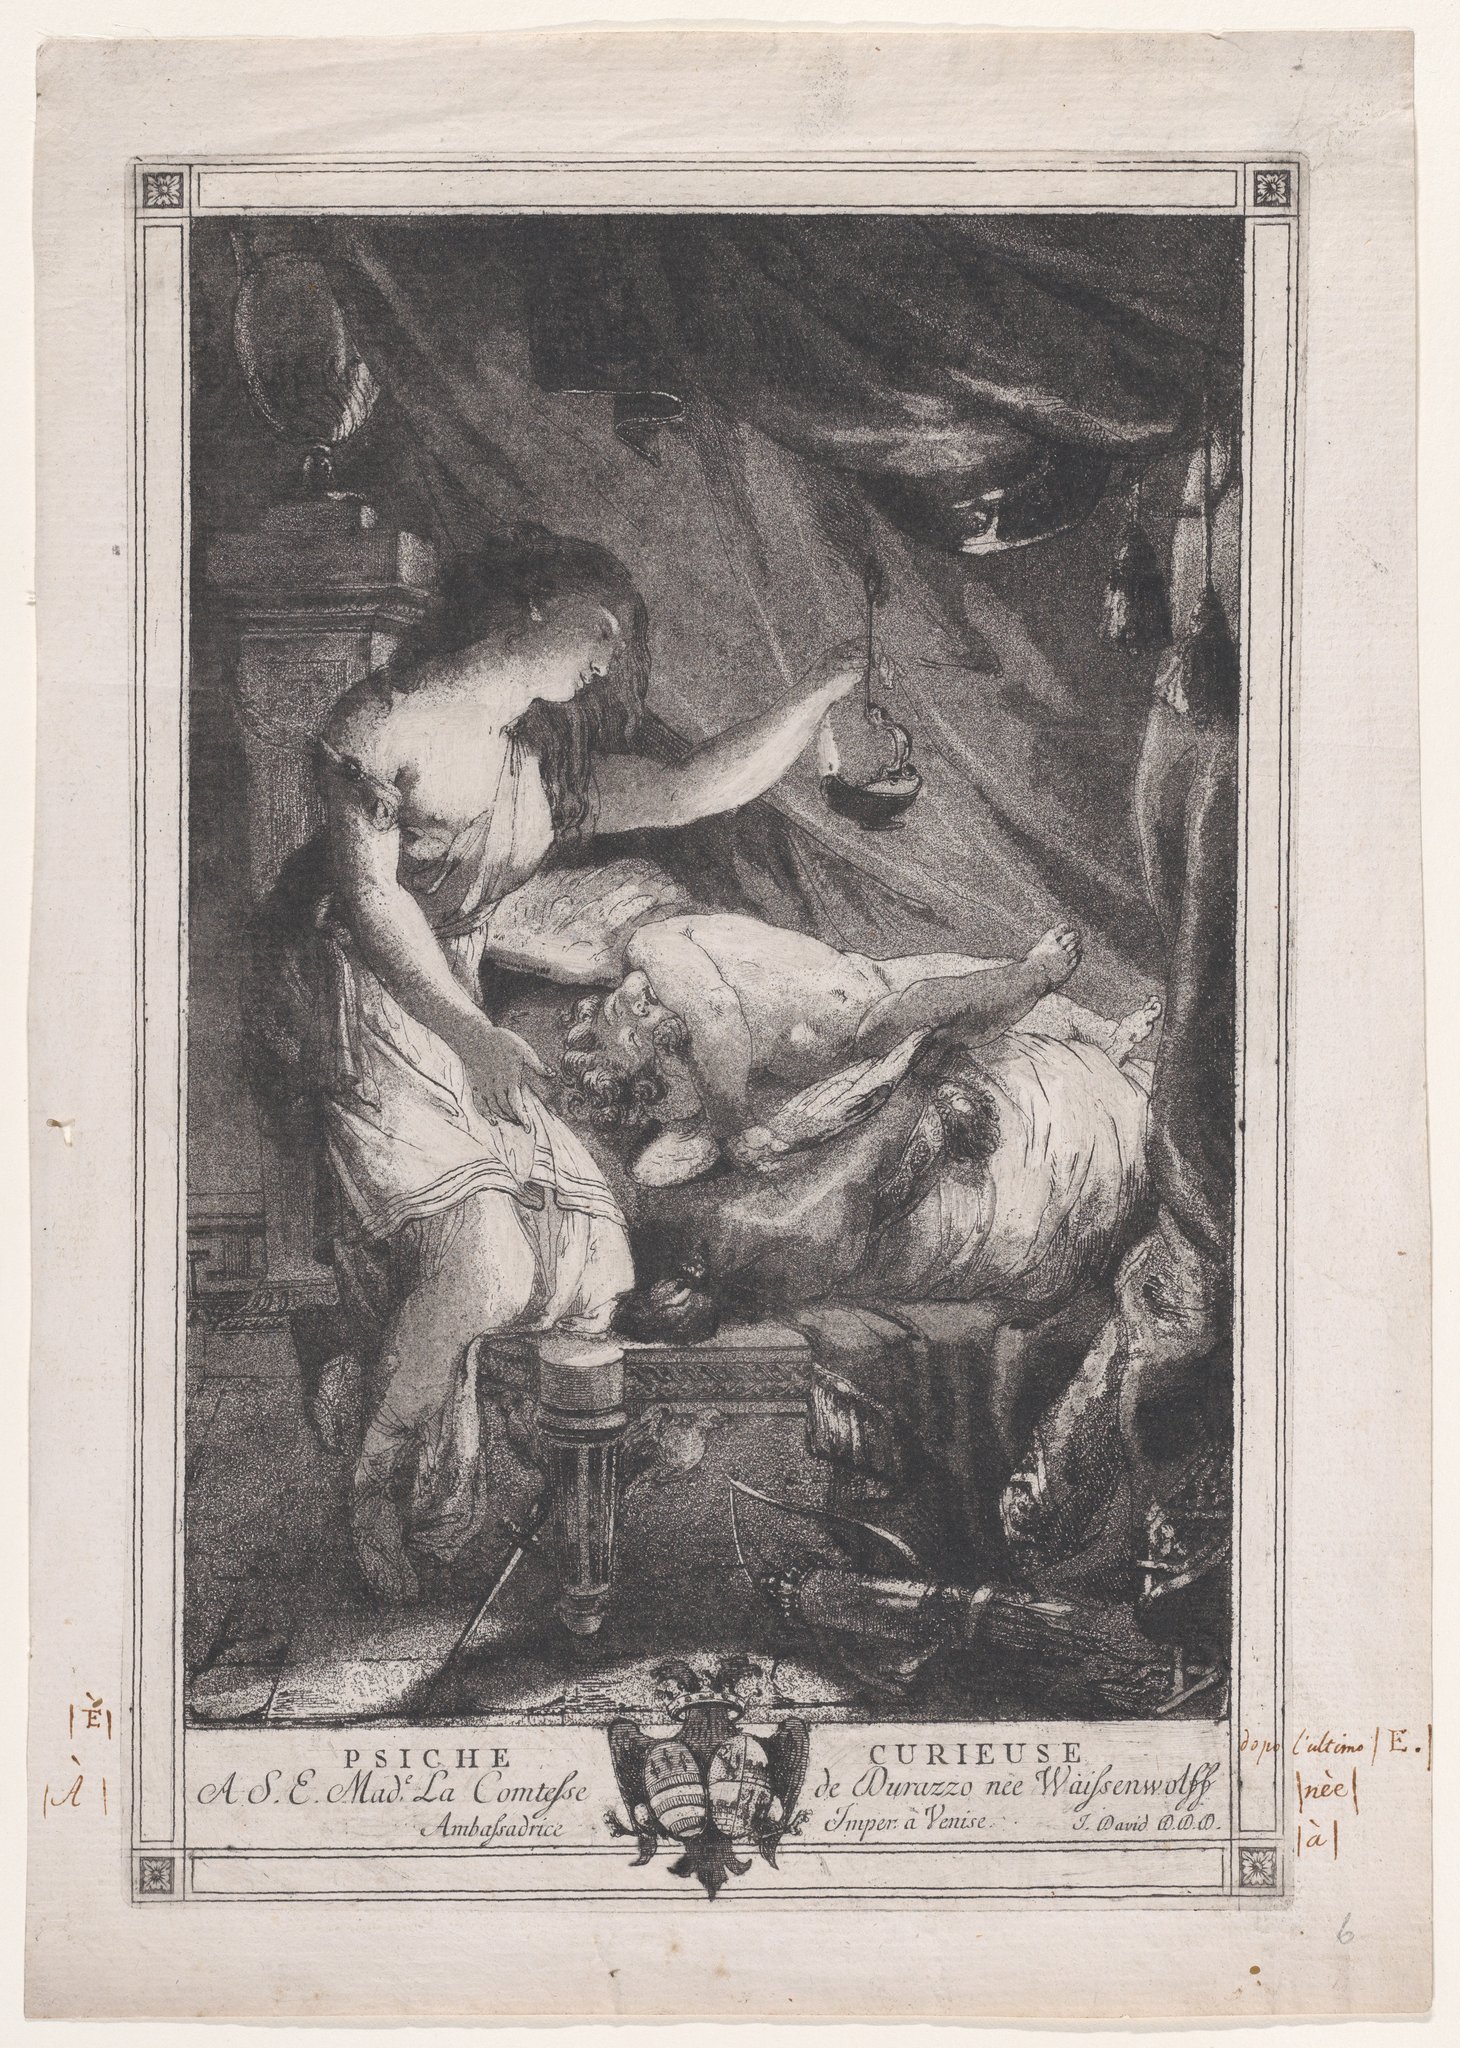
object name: print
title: Curious Psyche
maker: giovanni david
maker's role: artist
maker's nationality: italian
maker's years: 1749-1790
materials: ink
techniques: aquatint, etching, pen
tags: eros,psyche